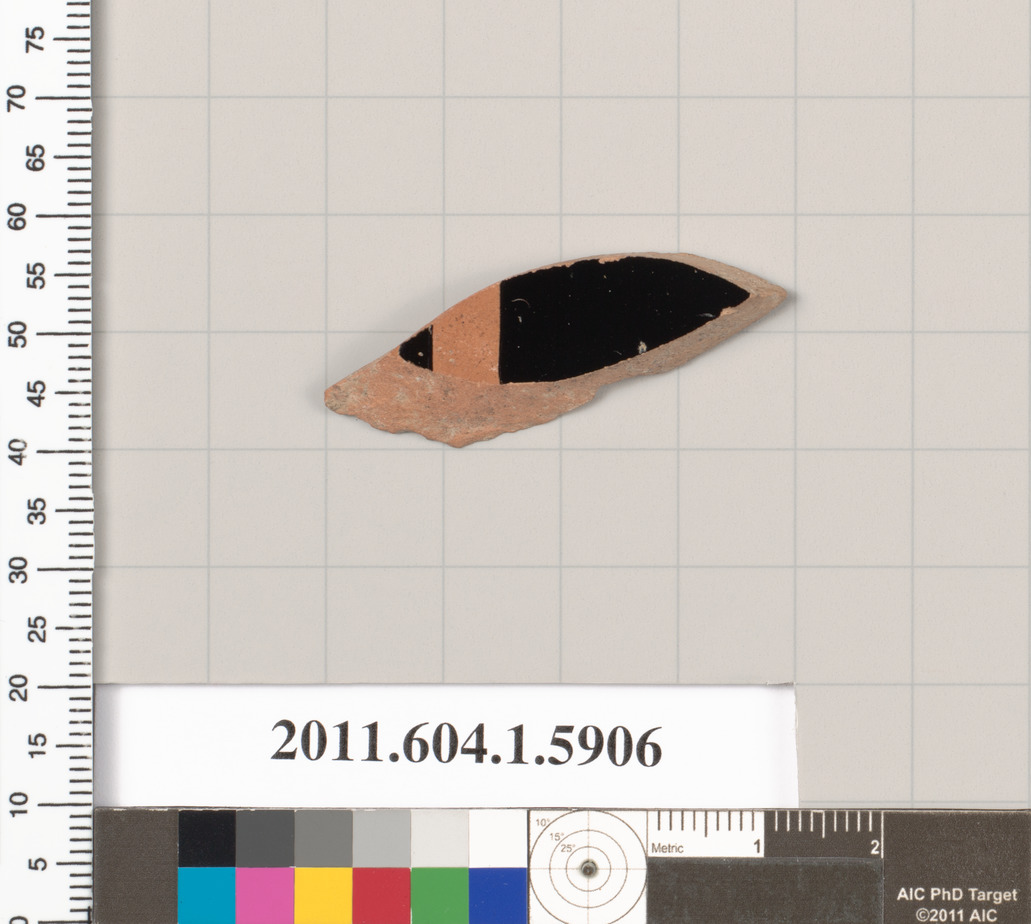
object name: kylix fragment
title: Terracotta fragment of a kylix (drinking cup)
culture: greek, attic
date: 520-510 BCE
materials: terracotta